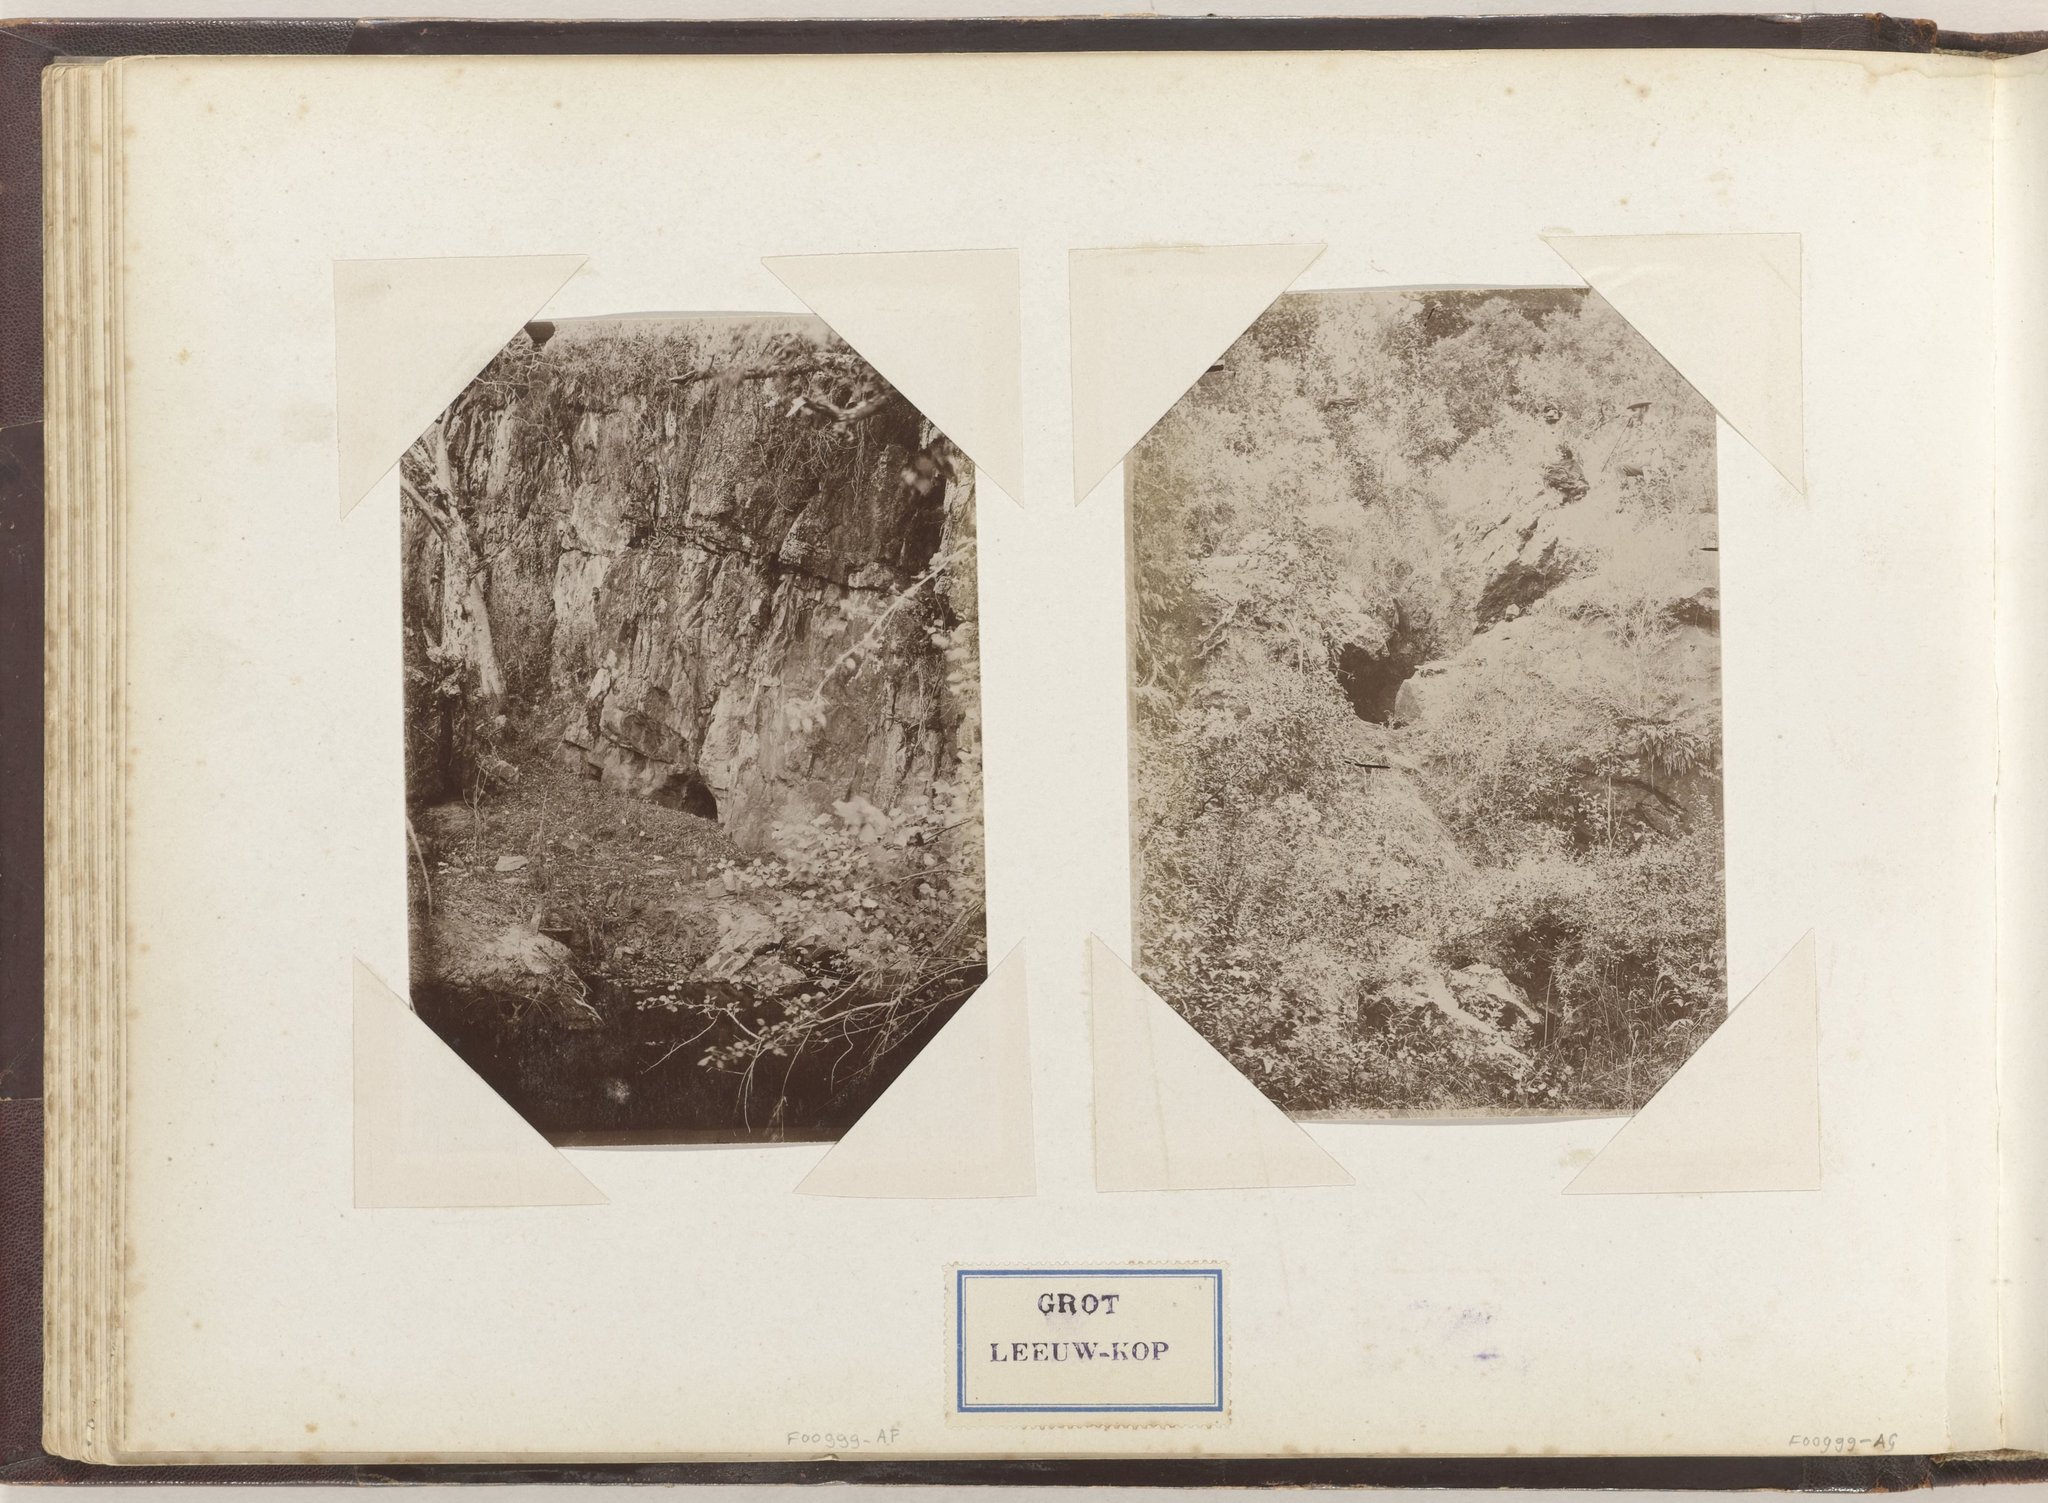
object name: photograph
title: Grot Leeuw-Kop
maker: Anonymous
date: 1885-1910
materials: paper, photographic support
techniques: daylight paper print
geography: south africa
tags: cave, grotto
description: Onderdeel van Album met 191 foto's van een reis naar en door Zuid-Afrika.